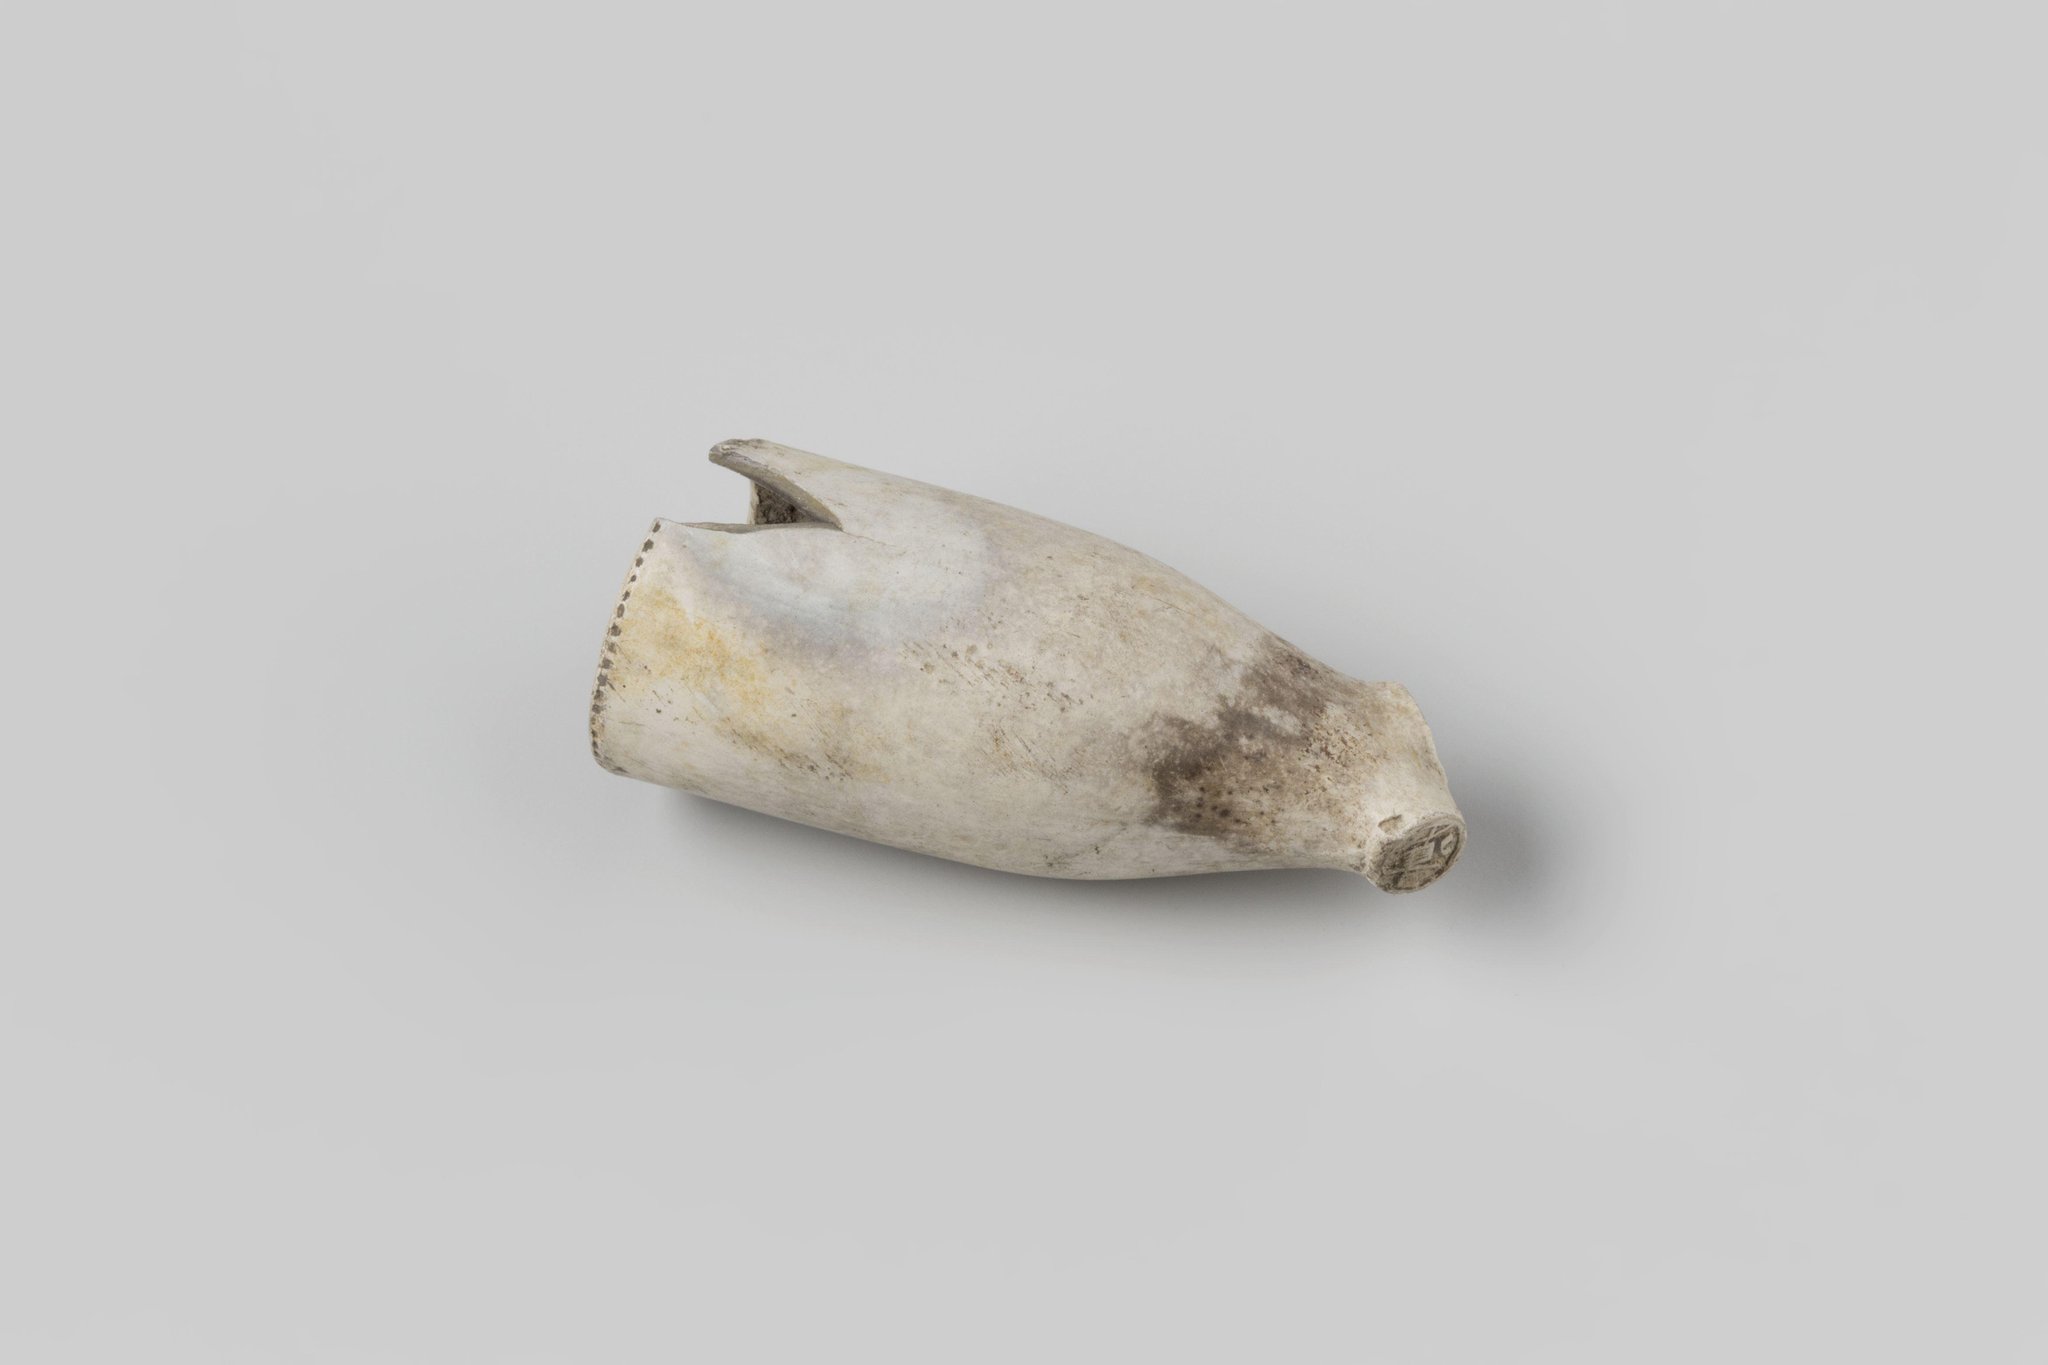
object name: fragment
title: Fragment pijpenkop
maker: jan pietersz schoonevelt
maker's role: pijpenfabrikant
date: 1720-1730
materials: clay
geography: gouda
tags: the hague, rotterdam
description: Fragment pijpenkop. Van de opgravingen op de Hofstede Arentsburg 1827-1831 onder toezicht van Professor Reuvens.